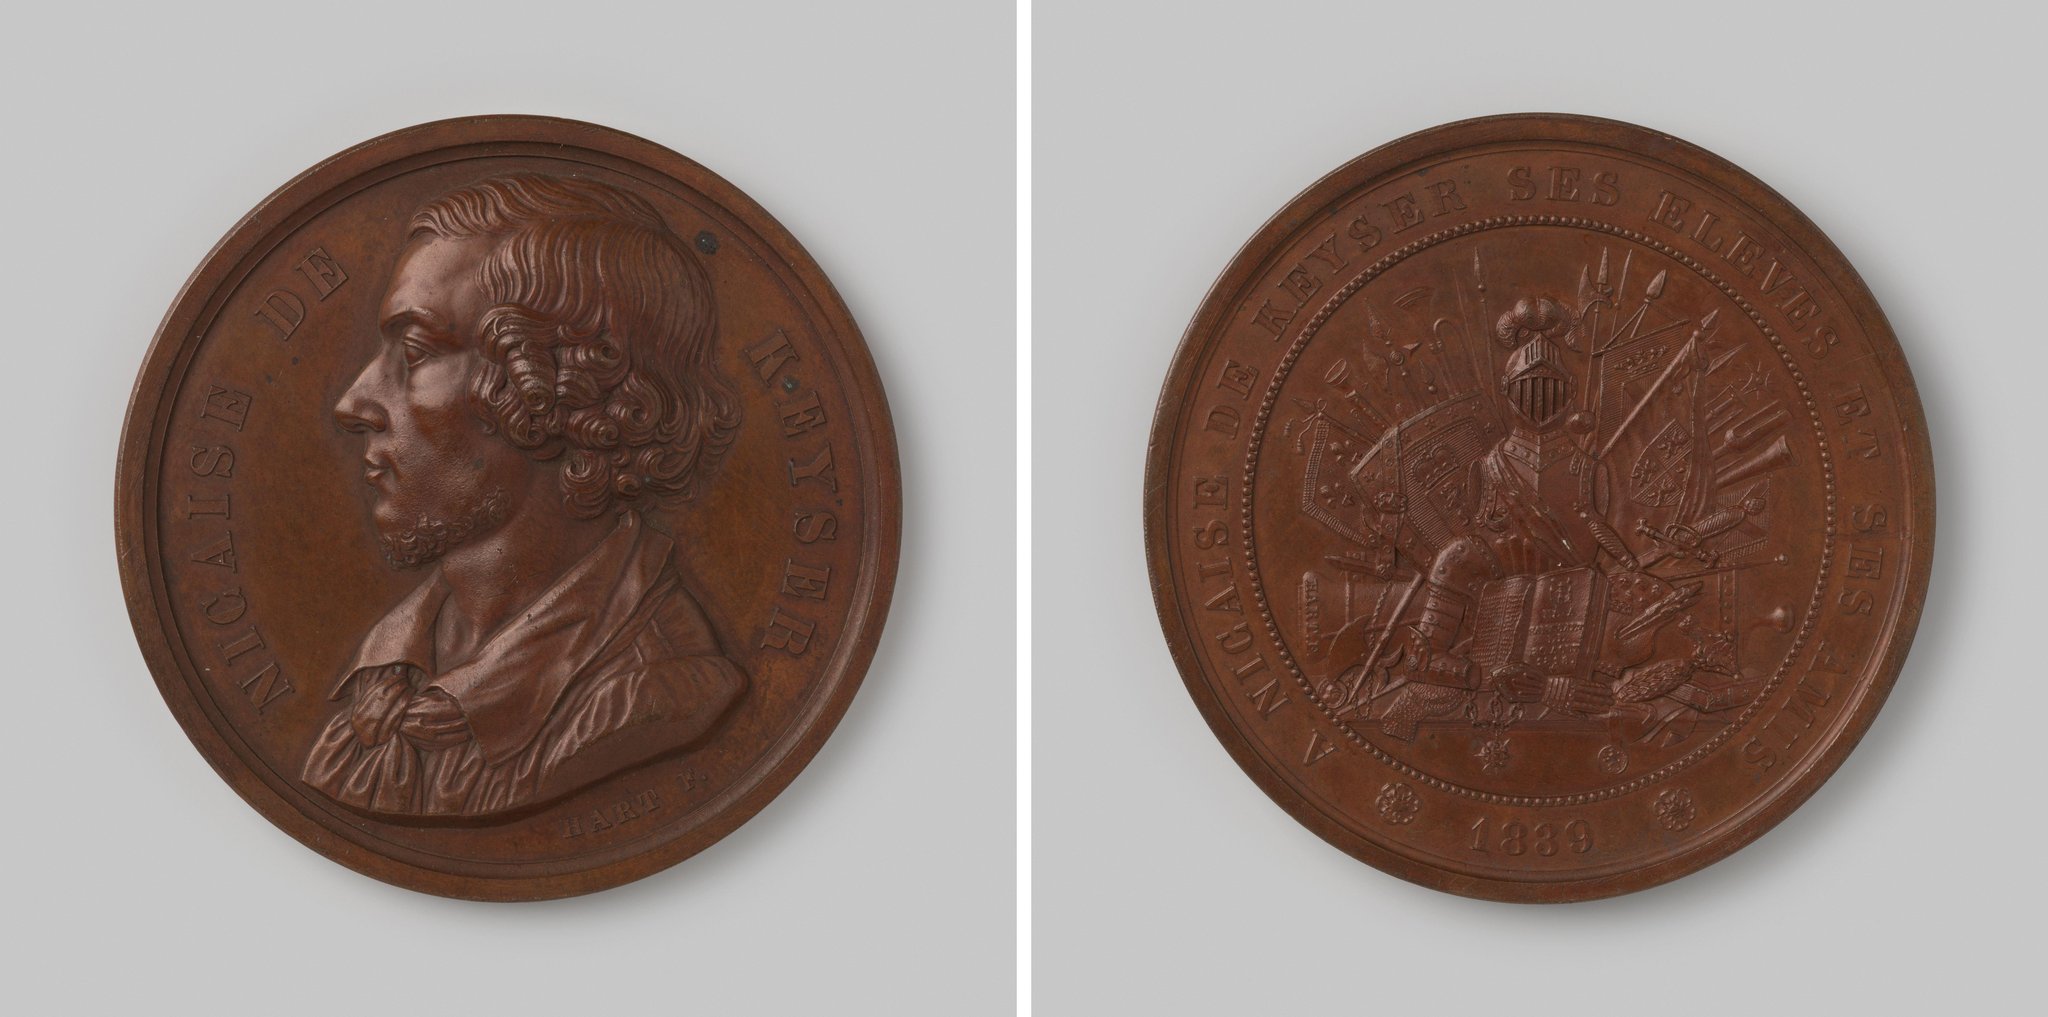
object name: history medal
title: Voltooiing van het schilderij De Slag bij Woeringen door Nicolas de Keyser 1839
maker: hart (stempelsnijder)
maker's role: die cutter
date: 1839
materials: bronze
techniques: striking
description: Bronzen penning, op de voorzijde het borstbeeld van De Keyser naar links met omschrift, op de keerzijde een trofee van krijgsbenodigdheden waarop een opengeslagen boek, met omschrift.